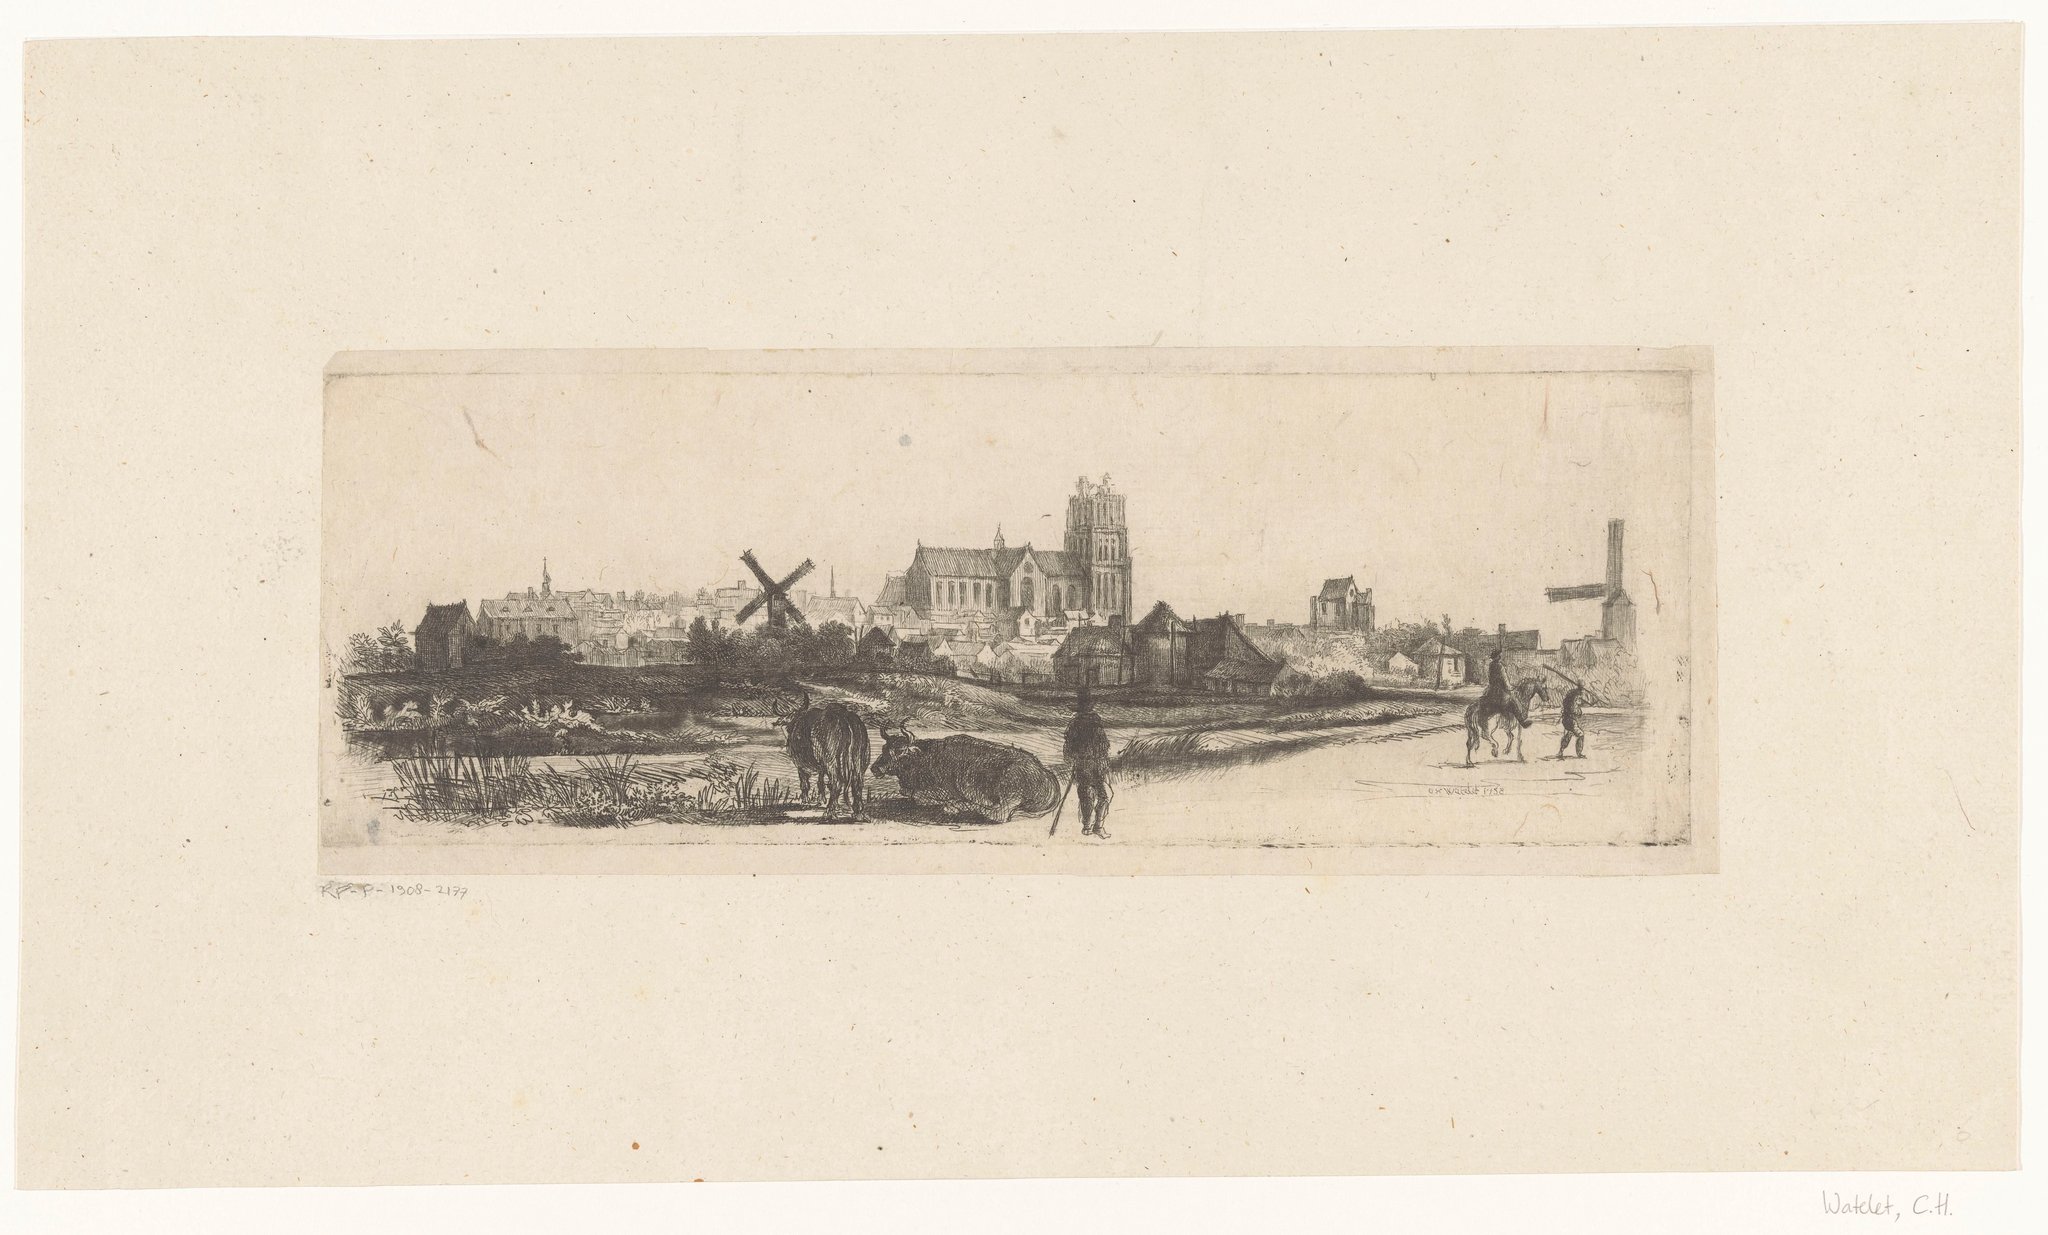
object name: print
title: Landschap met een gezicht op Dordrecht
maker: claude henri watelet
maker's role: print maker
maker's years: 1718-1786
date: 1758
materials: paper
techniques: etching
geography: france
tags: cow, church (exterior), landscapes (+ landscape with figures, staffage)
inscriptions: collector's mark: Lugt 2228